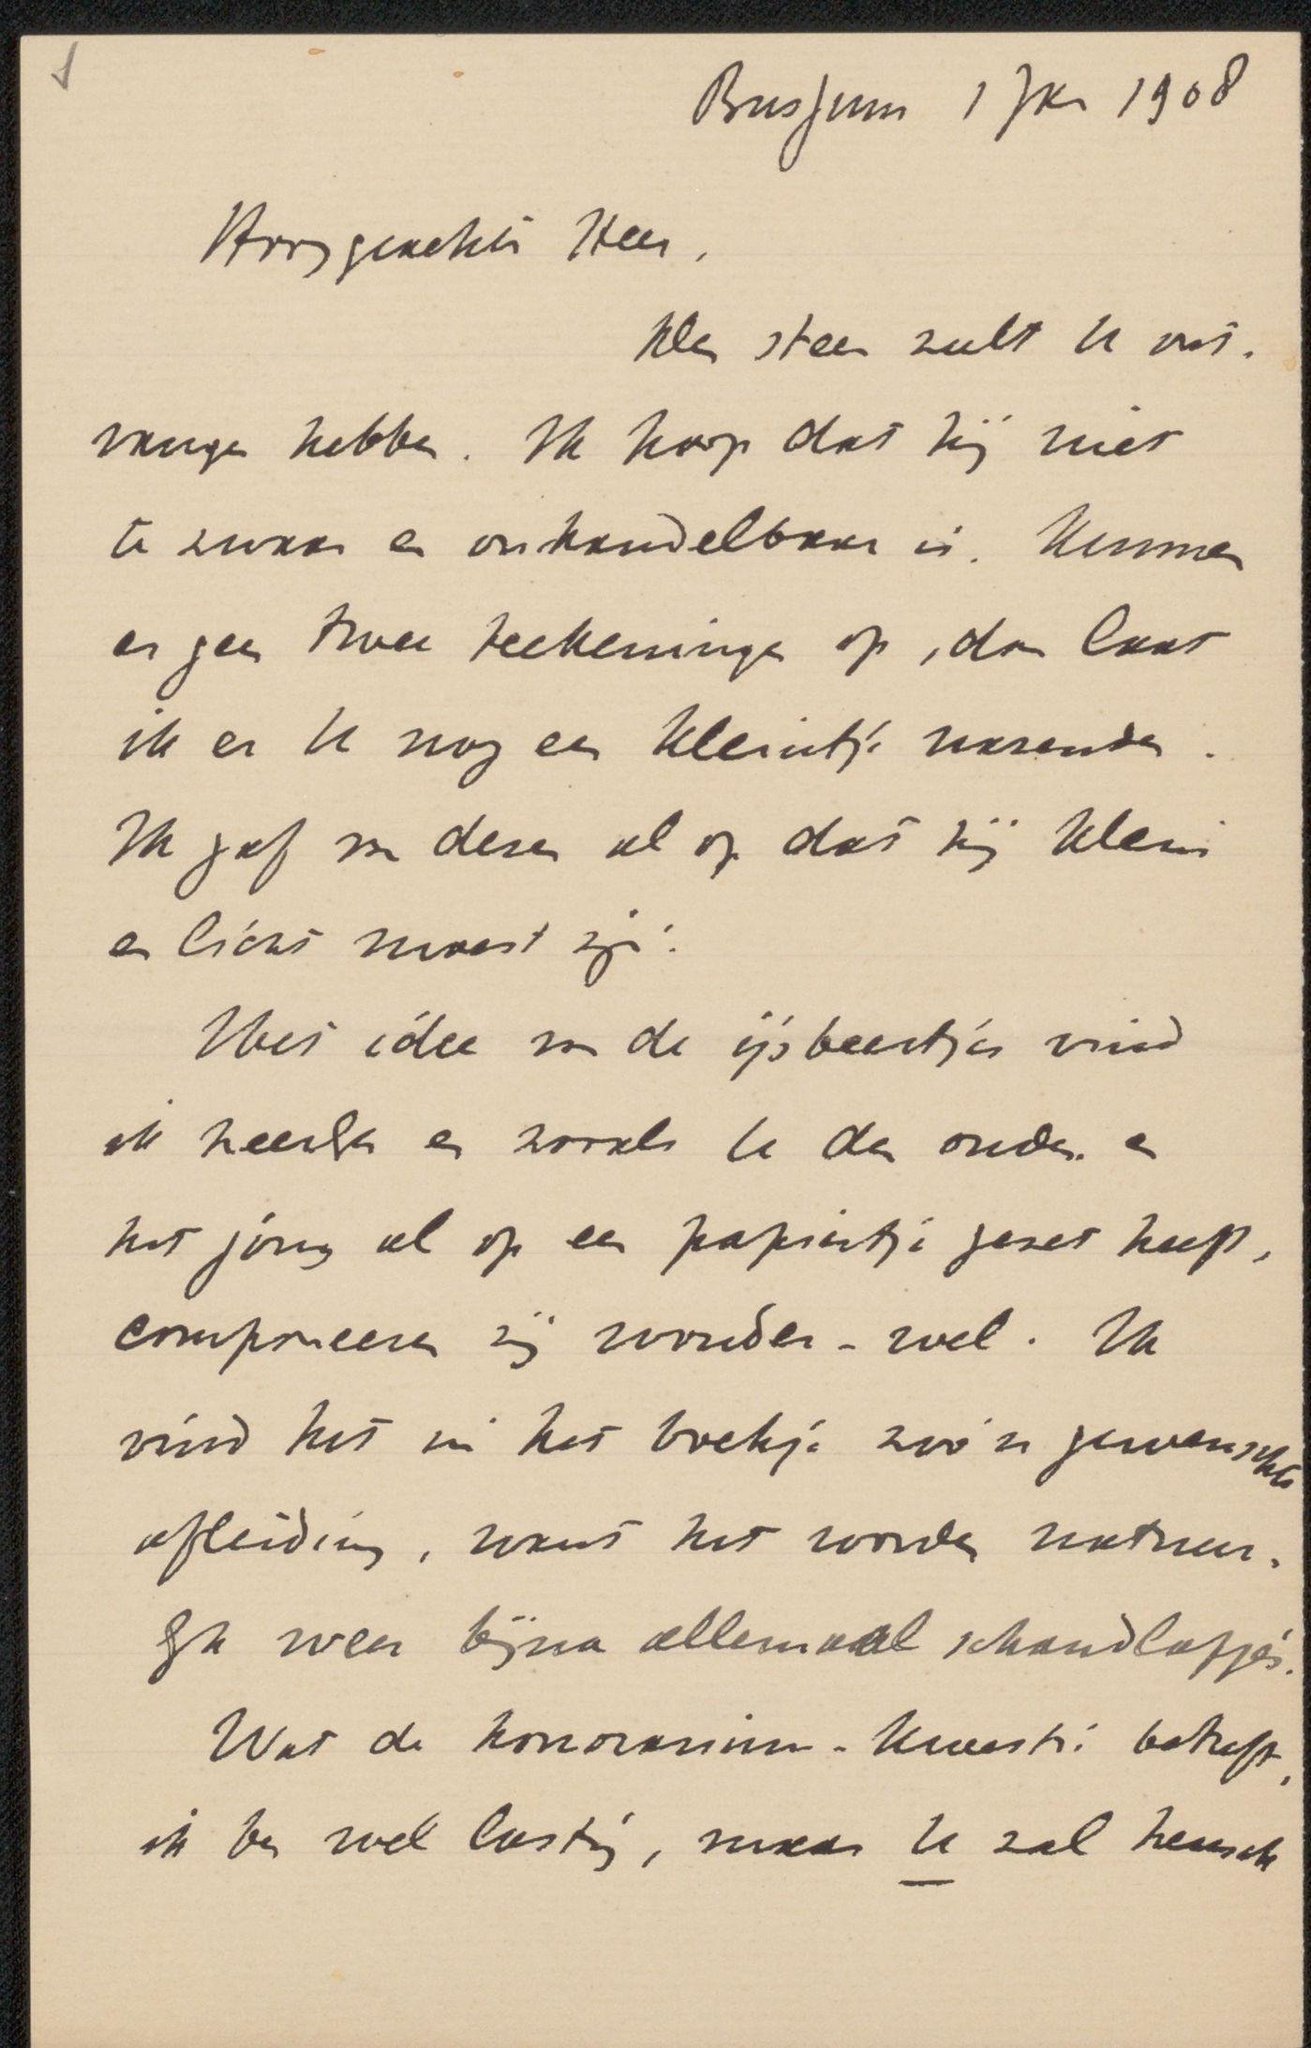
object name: letter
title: Brief aan August Allebé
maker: jan veth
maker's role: designer, draughtsman, painter, print maker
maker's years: 1864-1925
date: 1908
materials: ink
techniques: pen, writing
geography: bussum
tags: amsterdam, print maker, draughtsman, august allebé, drawing, the graphic arts, money, printed matter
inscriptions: collector's mark: ‘RPK’, watermark